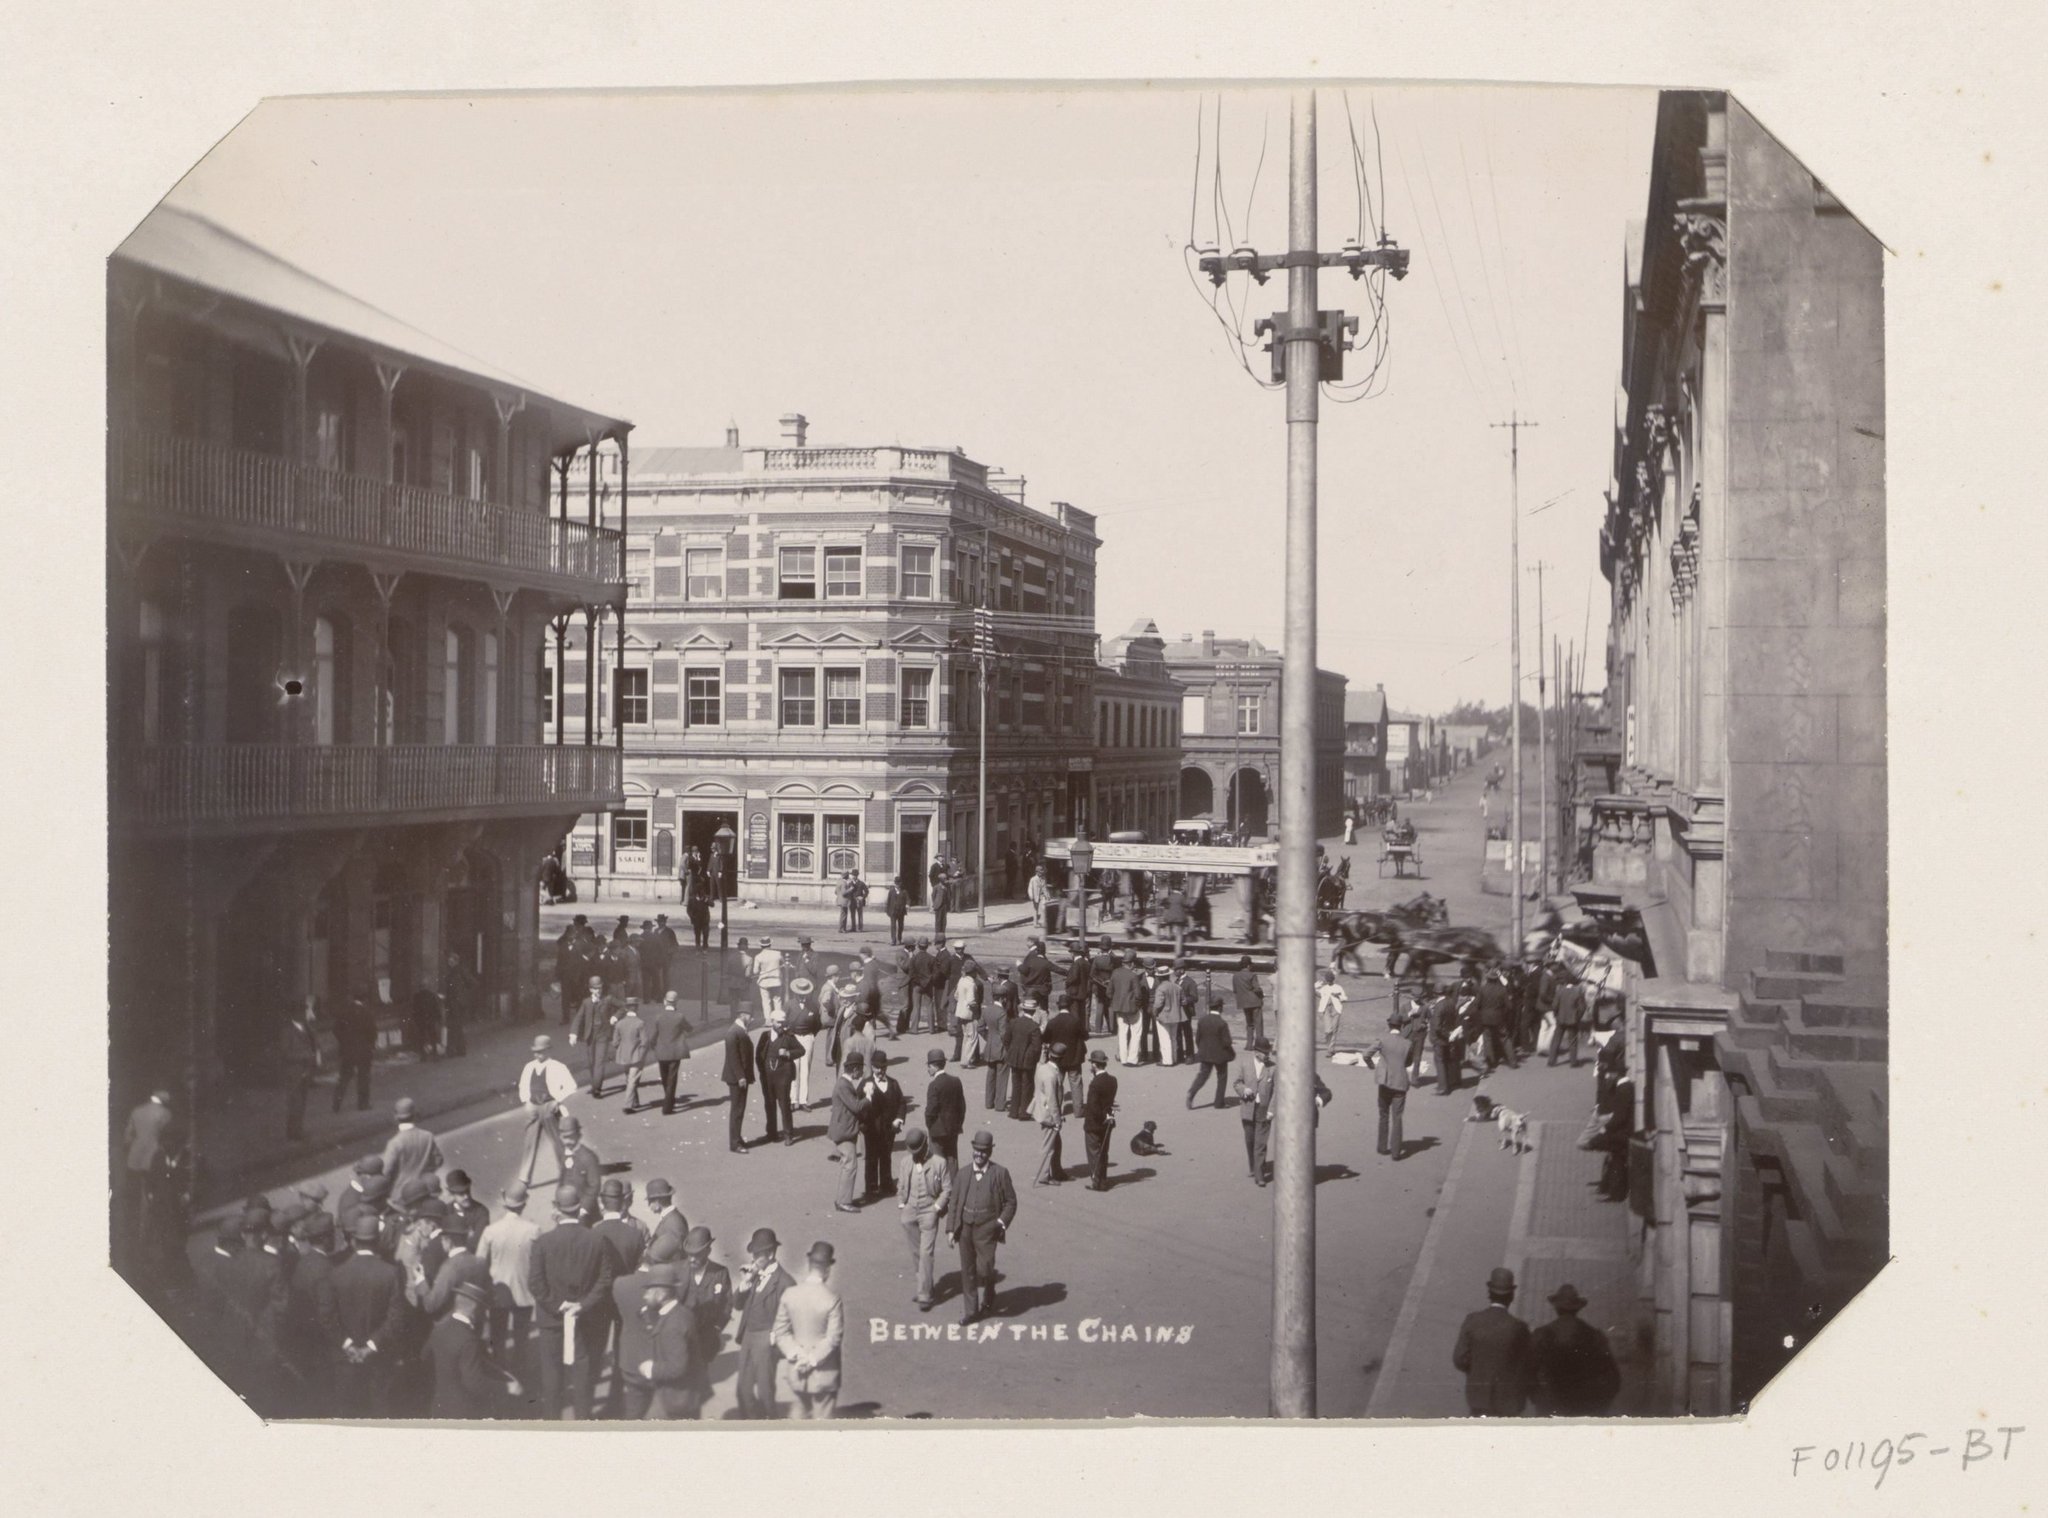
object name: photograph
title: Openlucht aandelenmarkt 'Between the Chains' in Johannesburg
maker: Anonymous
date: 1890-1920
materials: cardboard, paper, photographic support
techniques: gelatin silver print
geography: johannesburg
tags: stock exchange, stock-market, market, johannesburg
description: Onderdeel van Fotoalbum van een reis door de Verenigde Staten, Honolulu, Nederlands-Indië, Aden, Zanzibar en Zuidelijk Afrika.